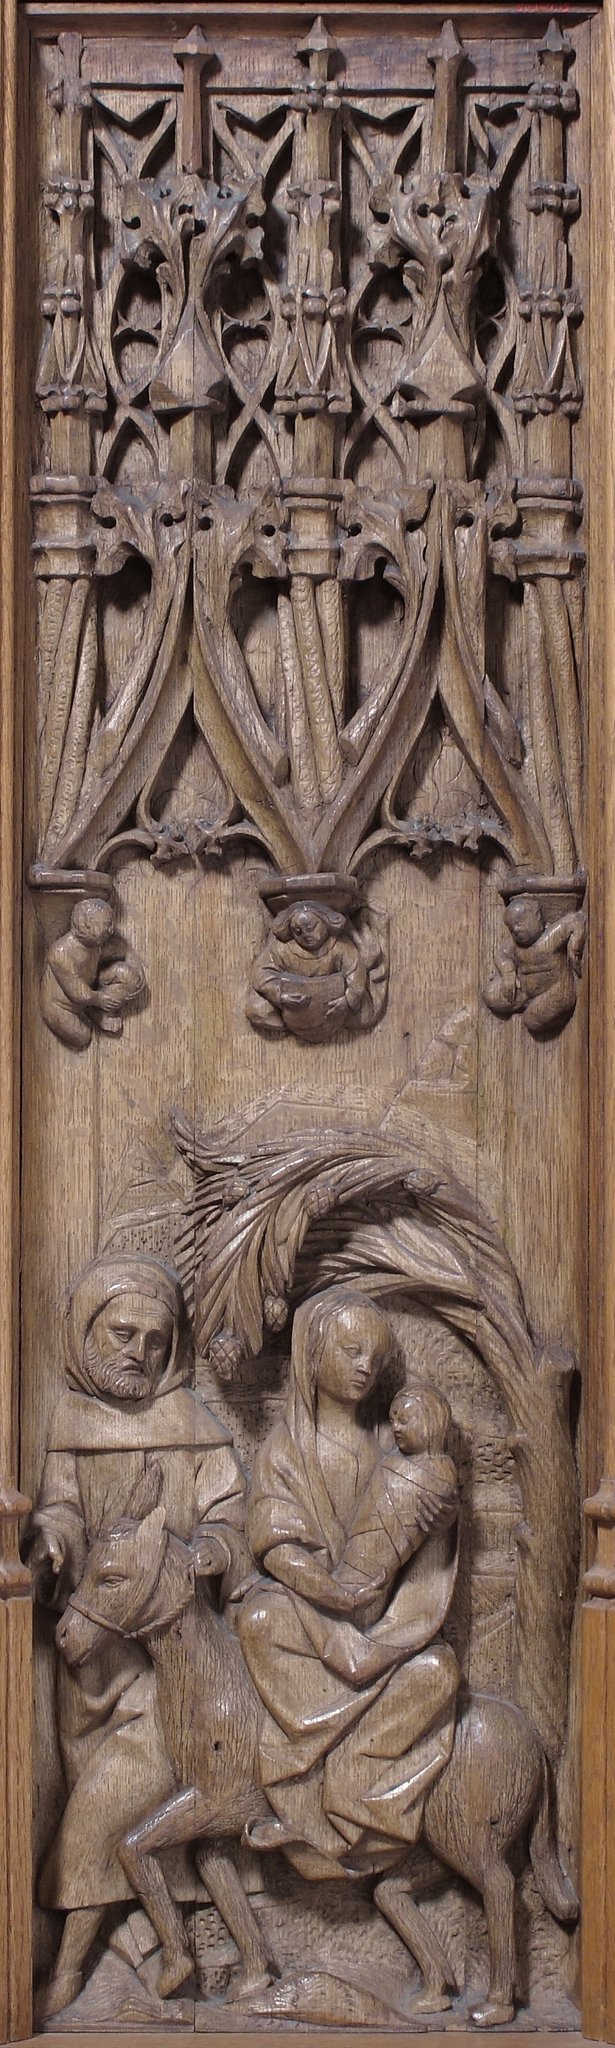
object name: panel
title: Panel with the Flight into Egypt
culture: french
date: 1501-1533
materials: wood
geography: france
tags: men,donkeys,madonna and child